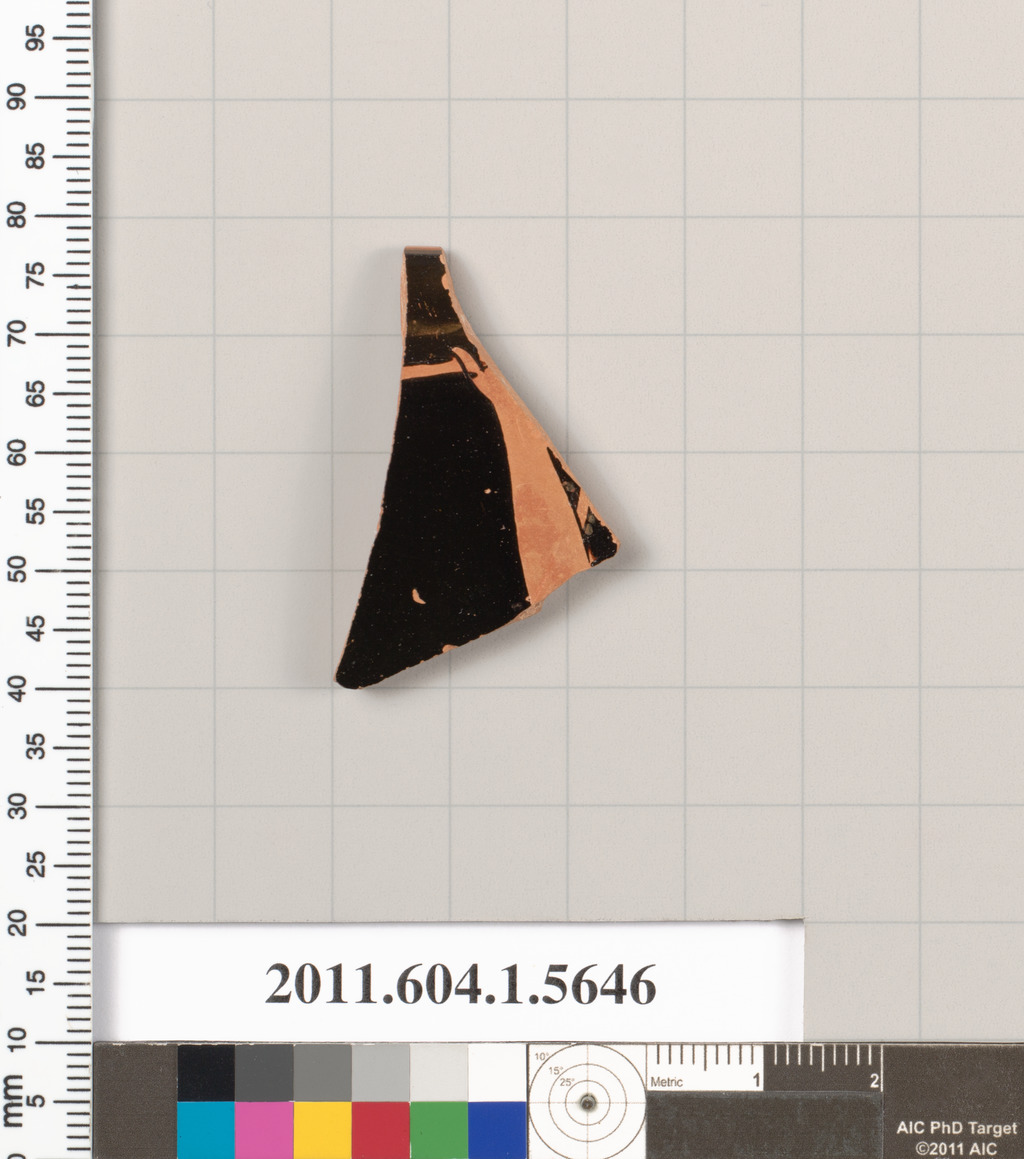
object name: kylix fragment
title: Terracotta rim fragment of a kylix (drinking cup)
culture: greek, attic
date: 500-480 BCE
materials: terracotta